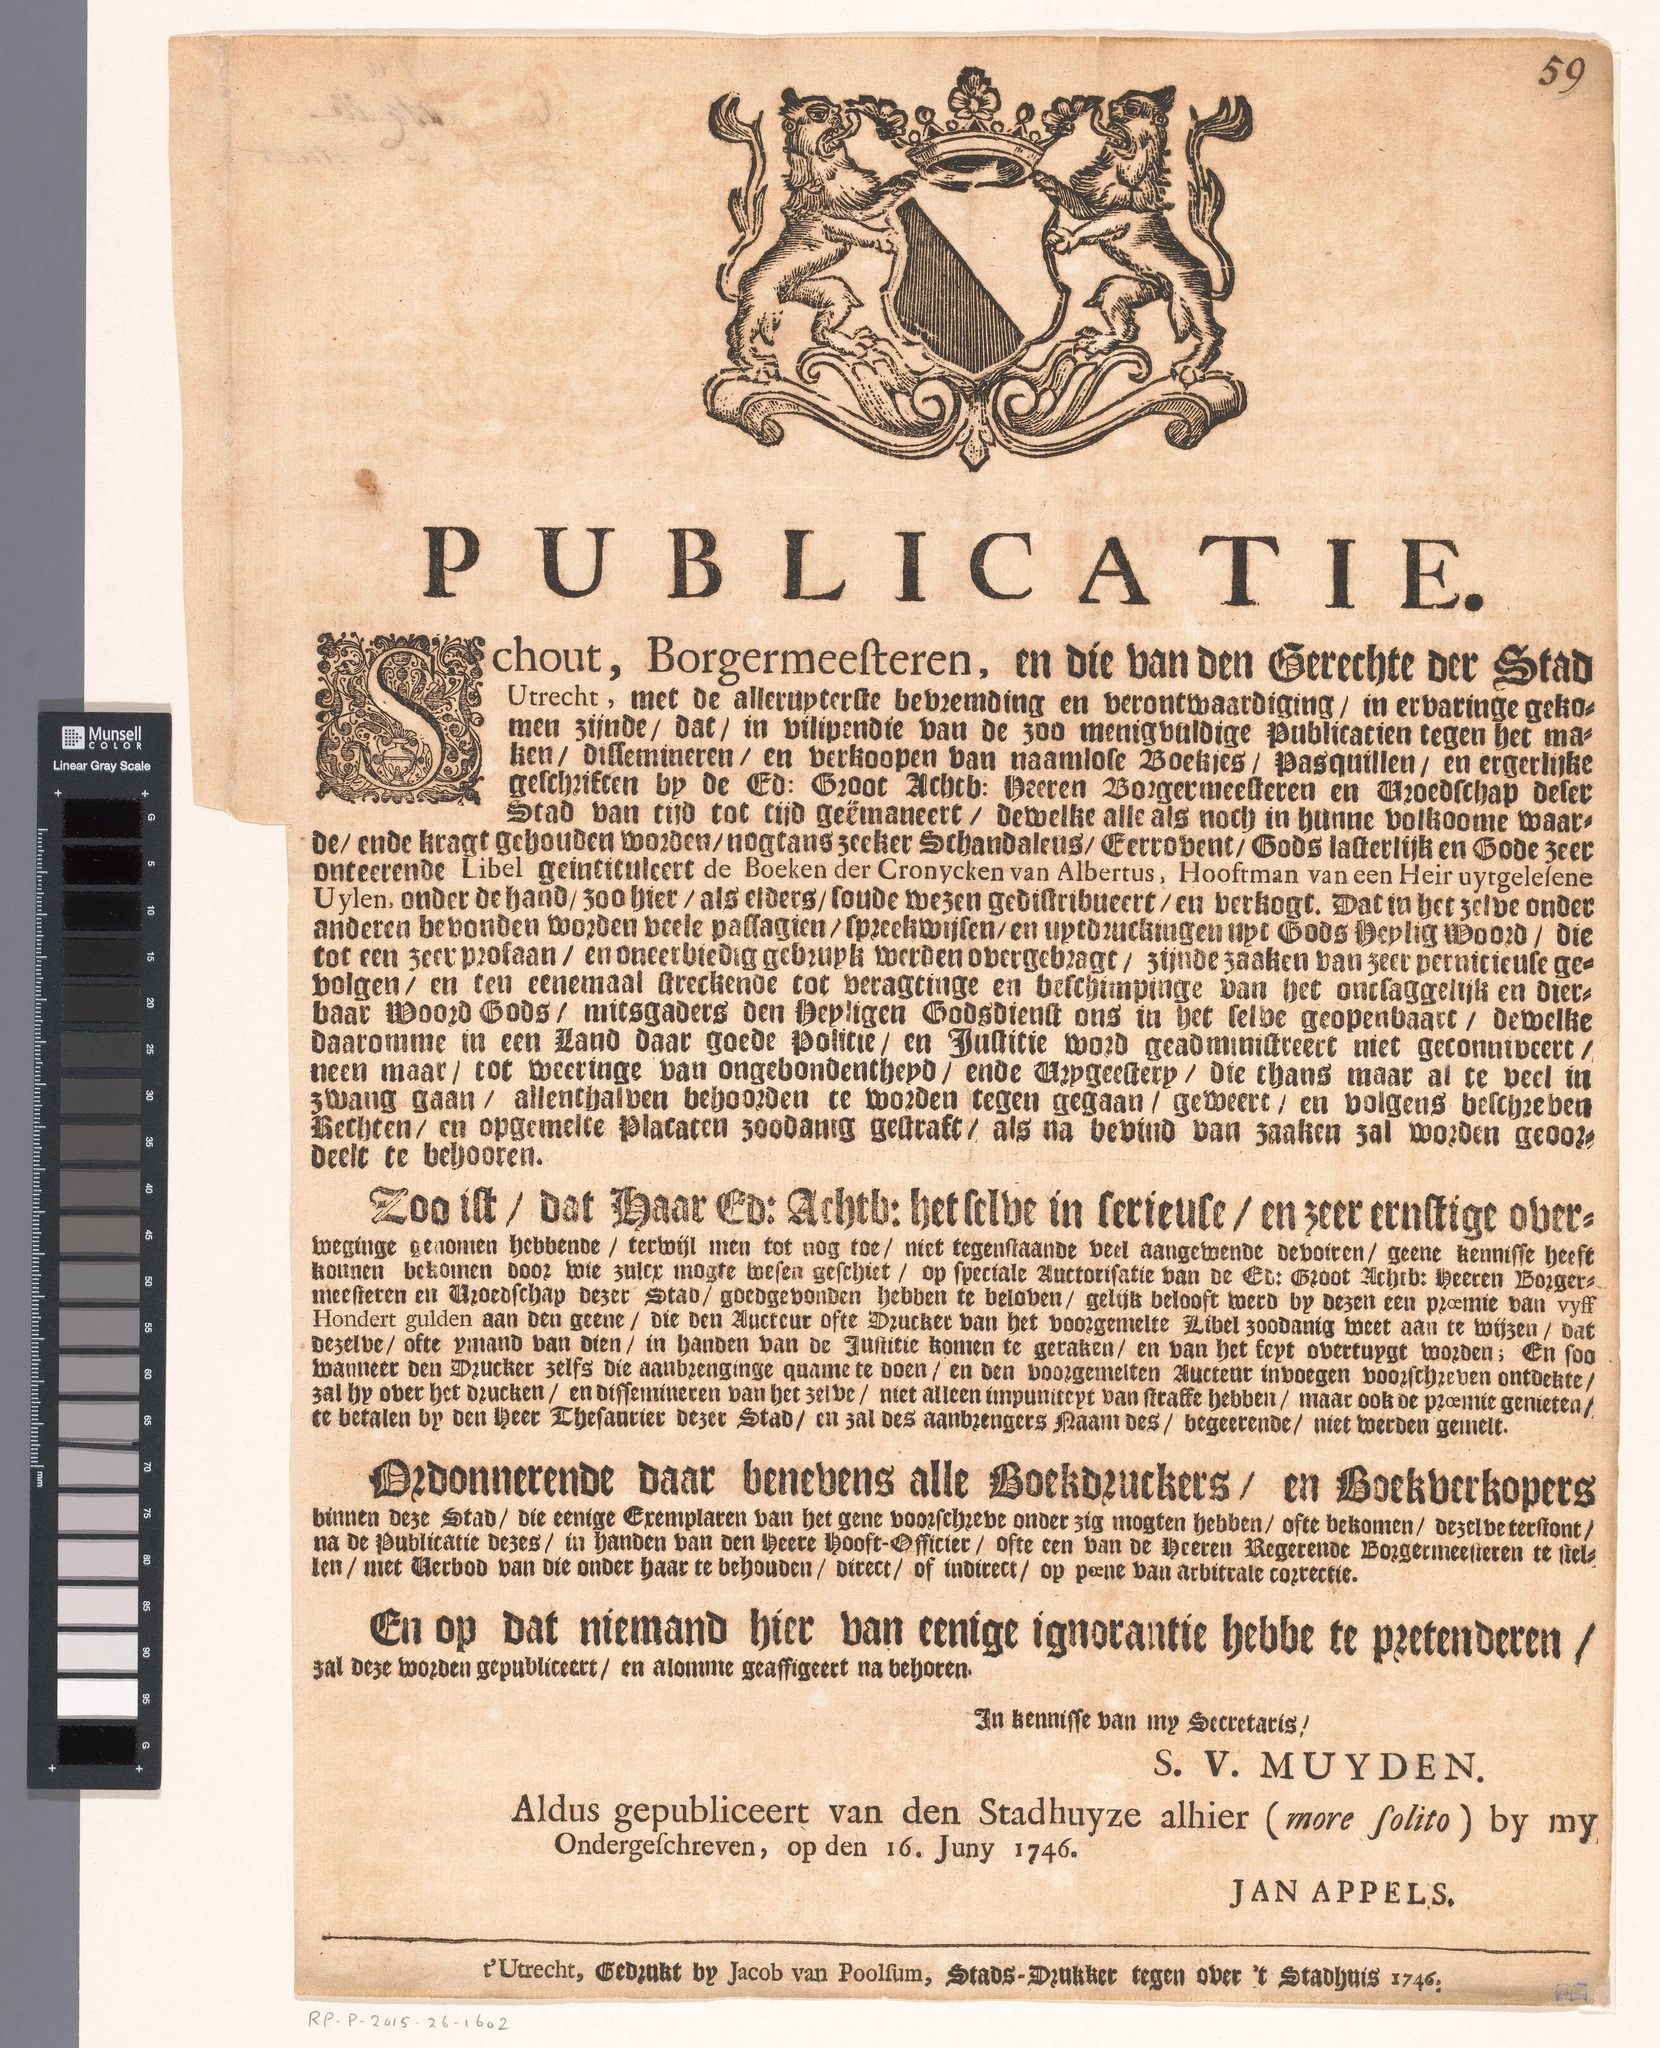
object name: print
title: Ordonnantie uitgevaardigd door de stad Utrecht aangaande boekdrukkers en boekverkopers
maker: jacob van poolsum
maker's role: printer, publisher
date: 1746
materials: paper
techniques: letterpress printing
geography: utrecht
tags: utrecht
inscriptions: number: ‘59’, annotation: ‘1746 / van pasquille en [...] / Cronijk van Alberth’, collector's mark: Lugt 4780, collector's mark: Lugt 4779, collector's mark: Lugt 2228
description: In de ordonnantie verbiedt het stadsbestuur van Utrecht de verspreiding van de publicatie (waarschijnlijk een pamflet) beschreven als: 'Boeken der Cronycken van Albertus, Hooftman van een Heir uytgelesene Uylen'. Ook wordt er een beloning van 500 gulden uitgeloofd voor degene die auteur of drukker van het geschrift aangeeft.